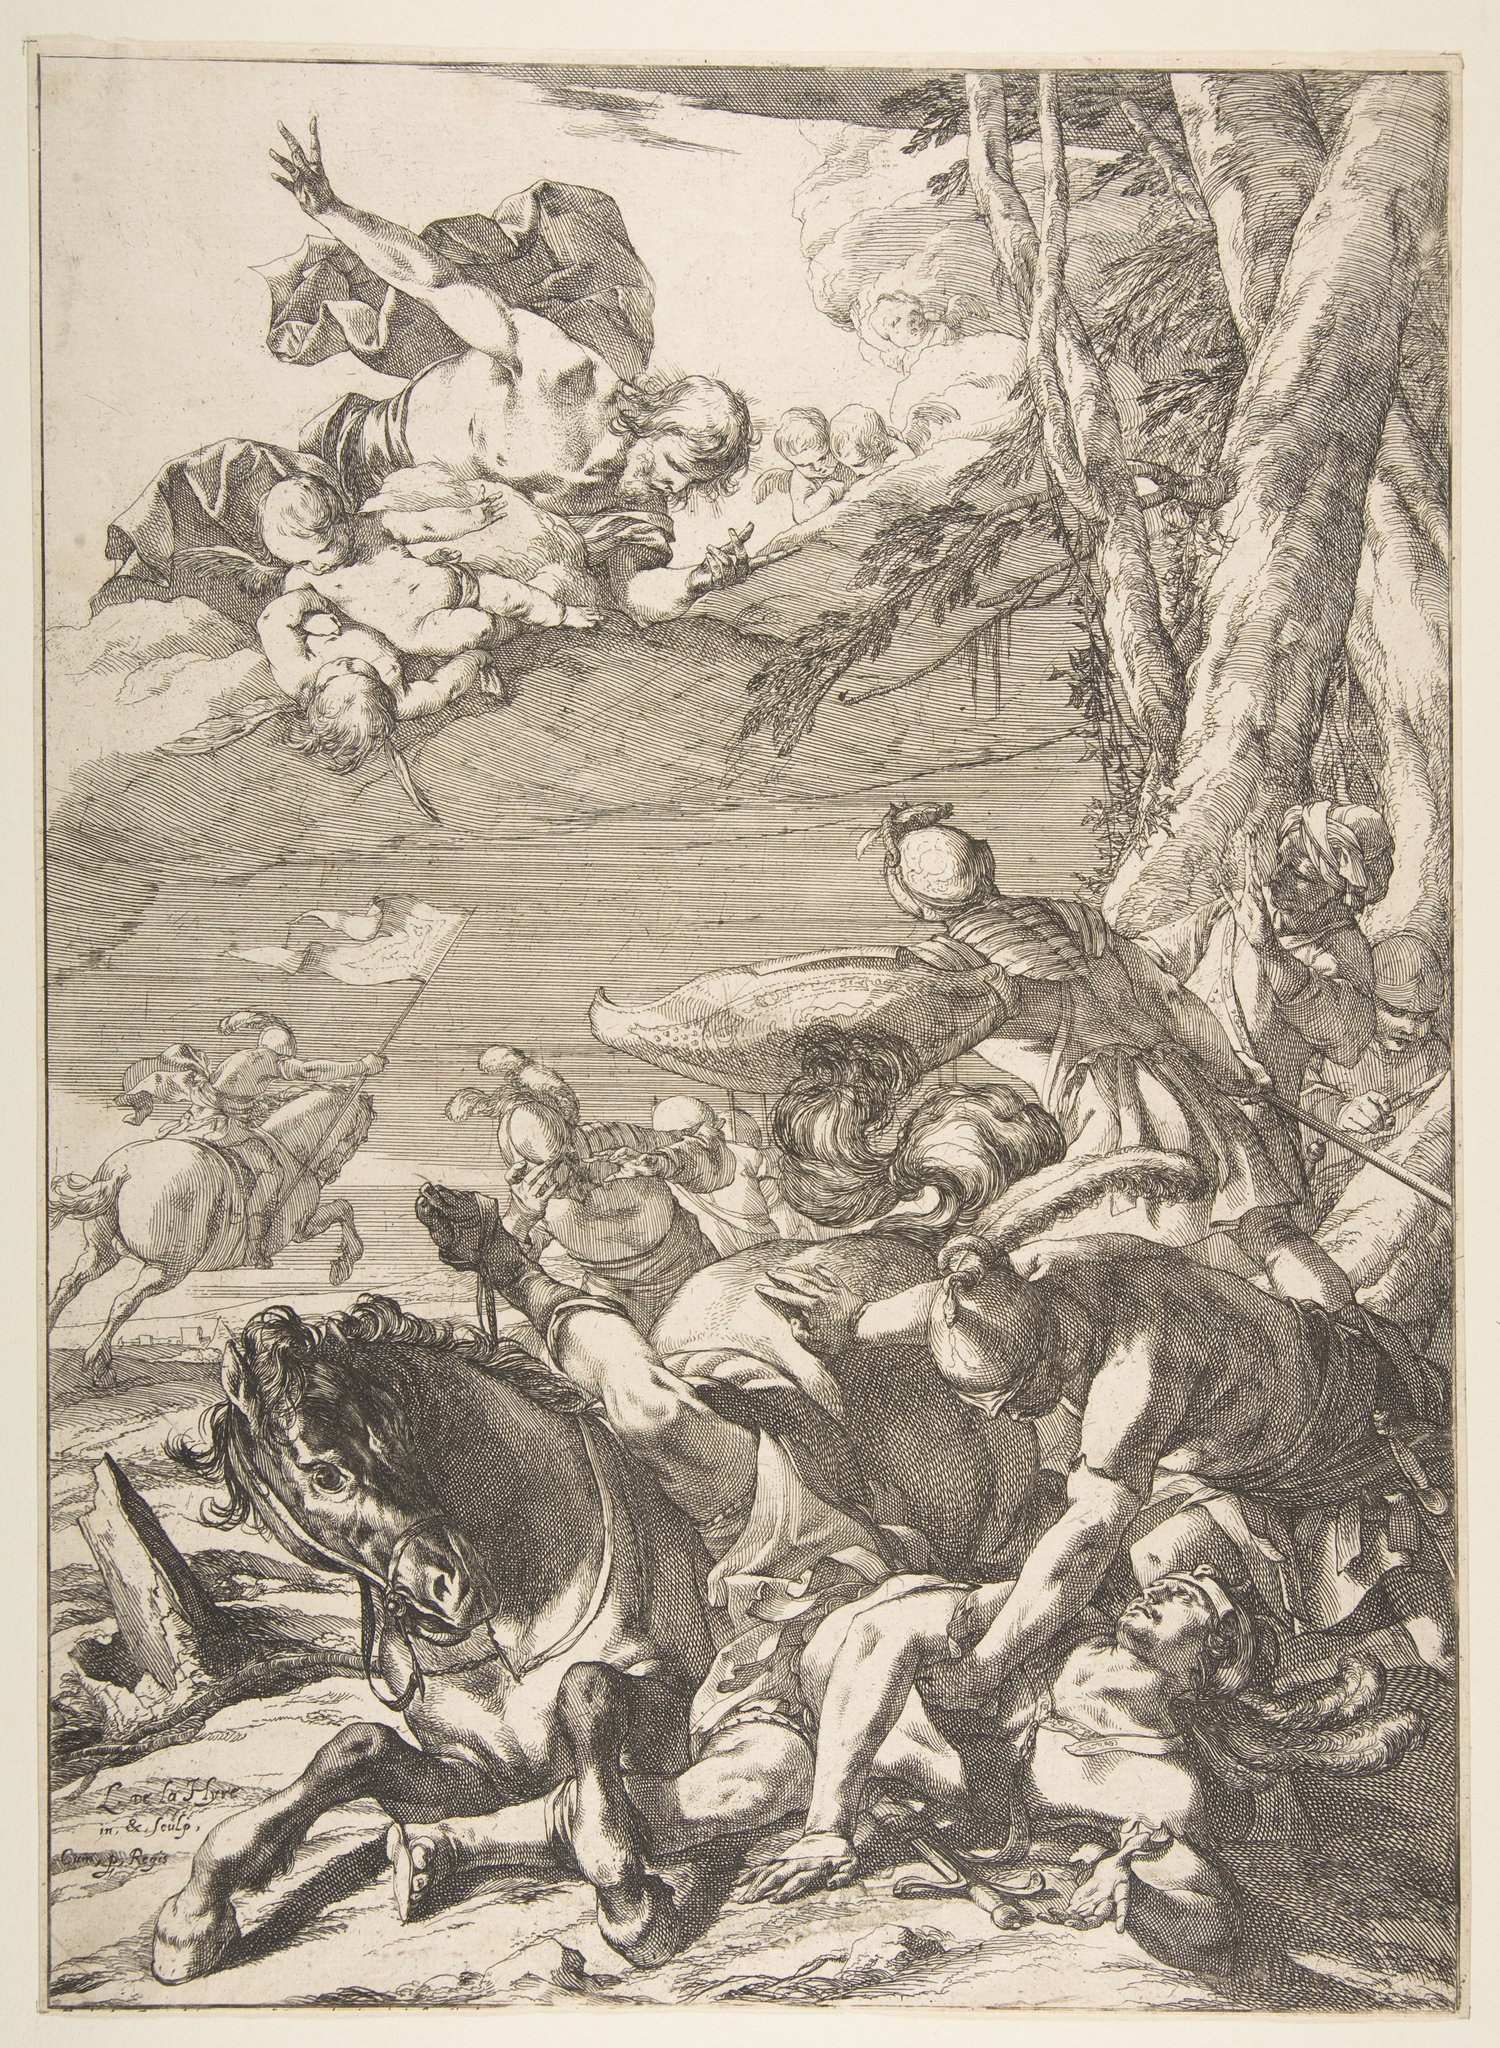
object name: print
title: Conversion of St. Paul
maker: laurent de la hyre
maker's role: artist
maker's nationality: french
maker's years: 1606-1656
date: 1637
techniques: etching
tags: men,horses,trees,angels,saint paul